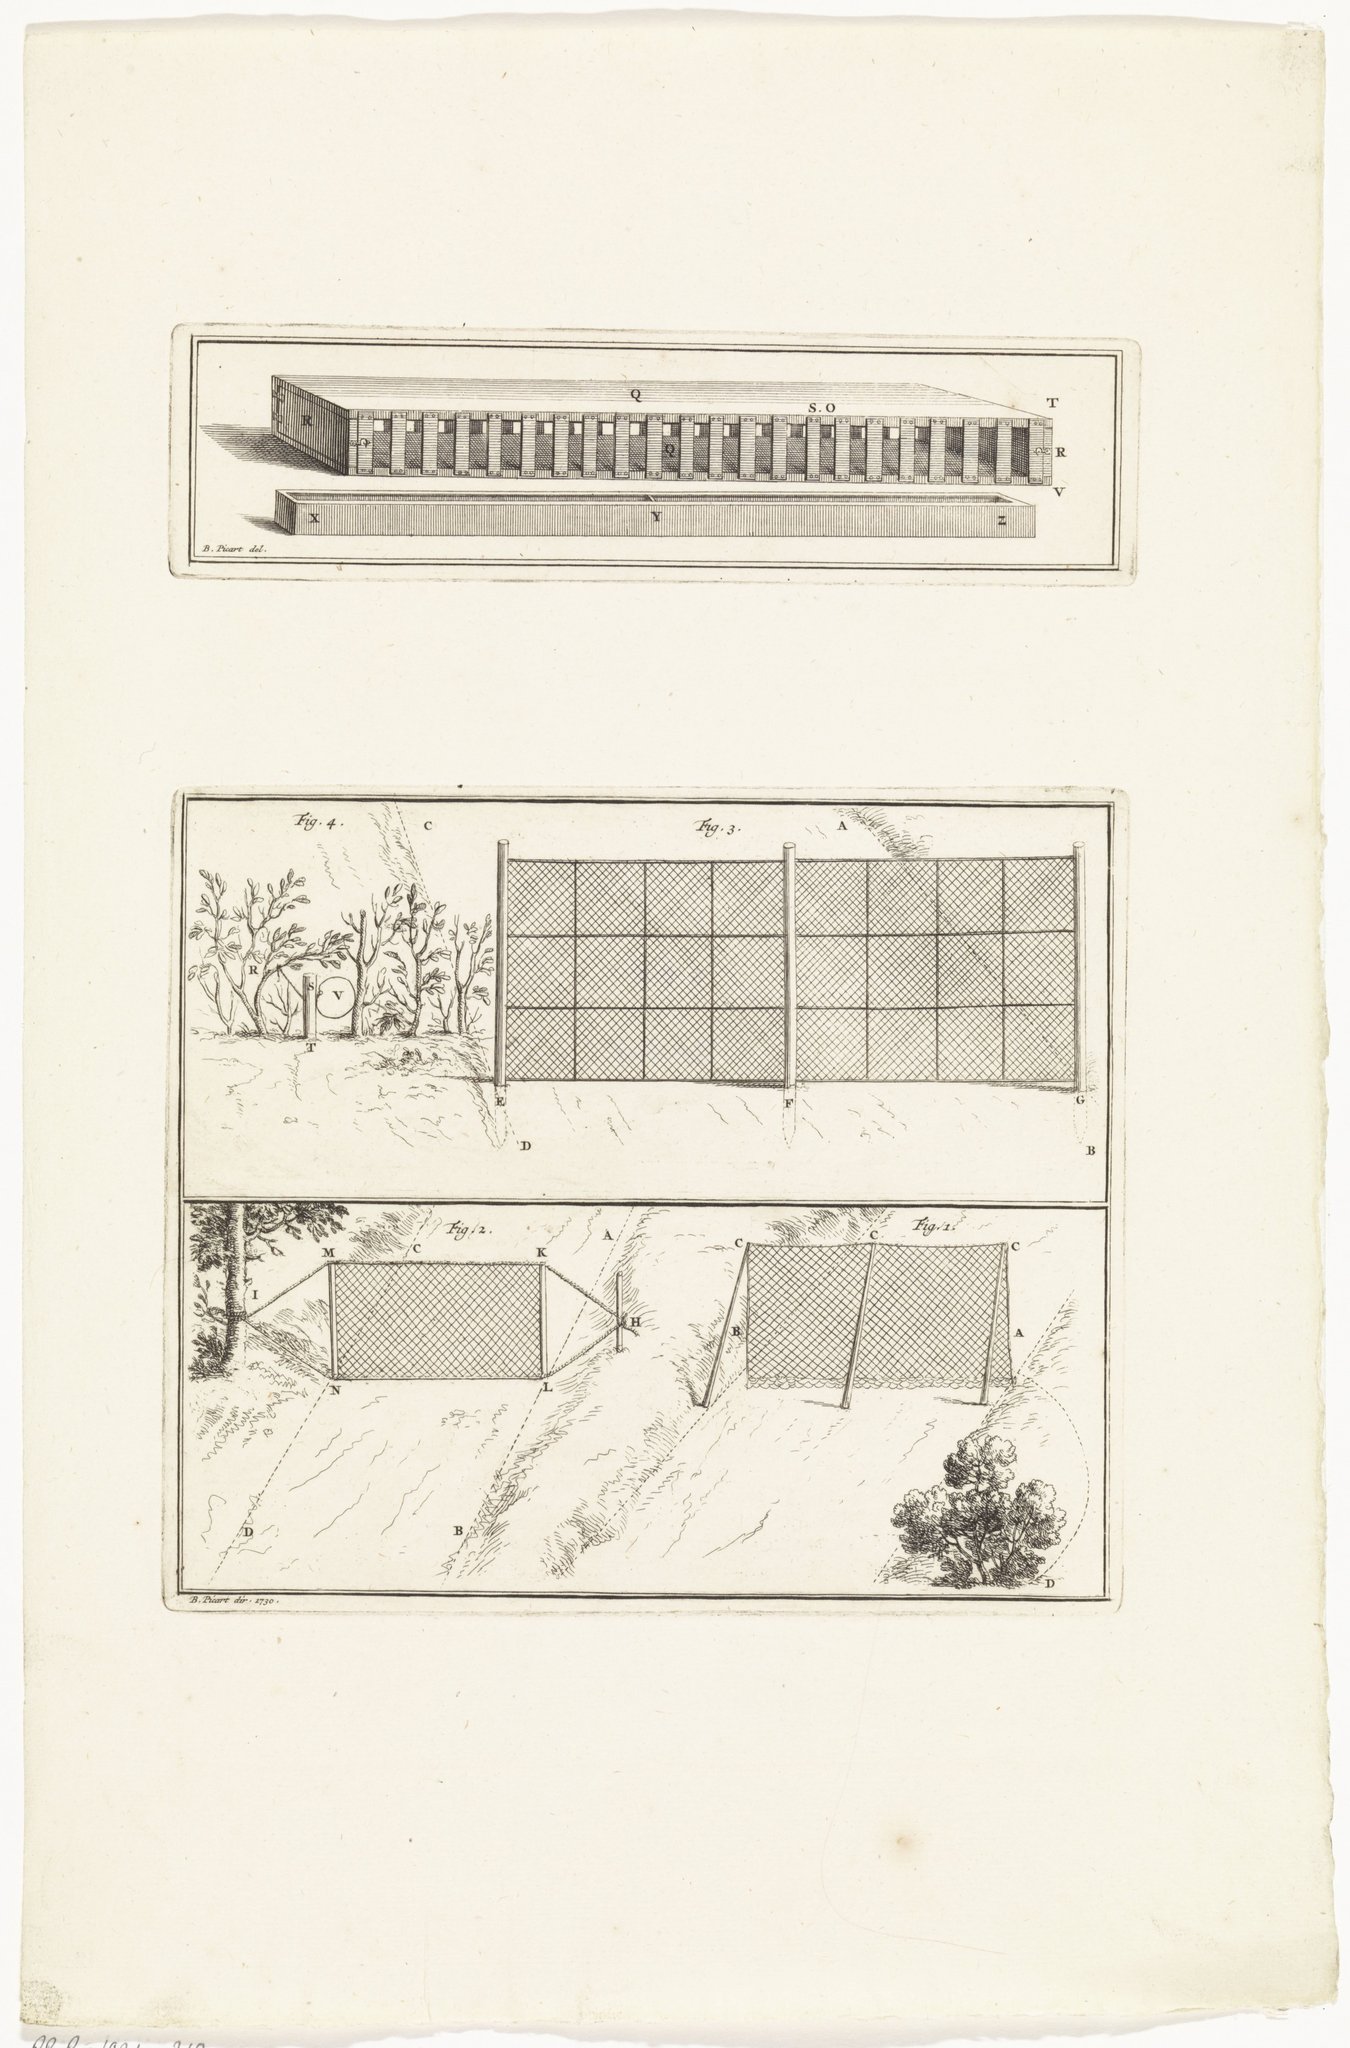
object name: book illustration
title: Platte kooi en dierenvallen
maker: bernard picart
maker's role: draughtsman, print maker, publisher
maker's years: 1673-1733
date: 1730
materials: paper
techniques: etching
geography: amsterdam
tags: bird hunting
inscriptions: collector's mark: Lugt 2233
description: Prenten bedoeld voor: Chomel, Noel. Dictionnaire oeconomique, contenant divers moïens d'augmenter son bien, et de conserver sa santé. Amsterdam: Johannes Covens en Cornelis Mortier, 1732.